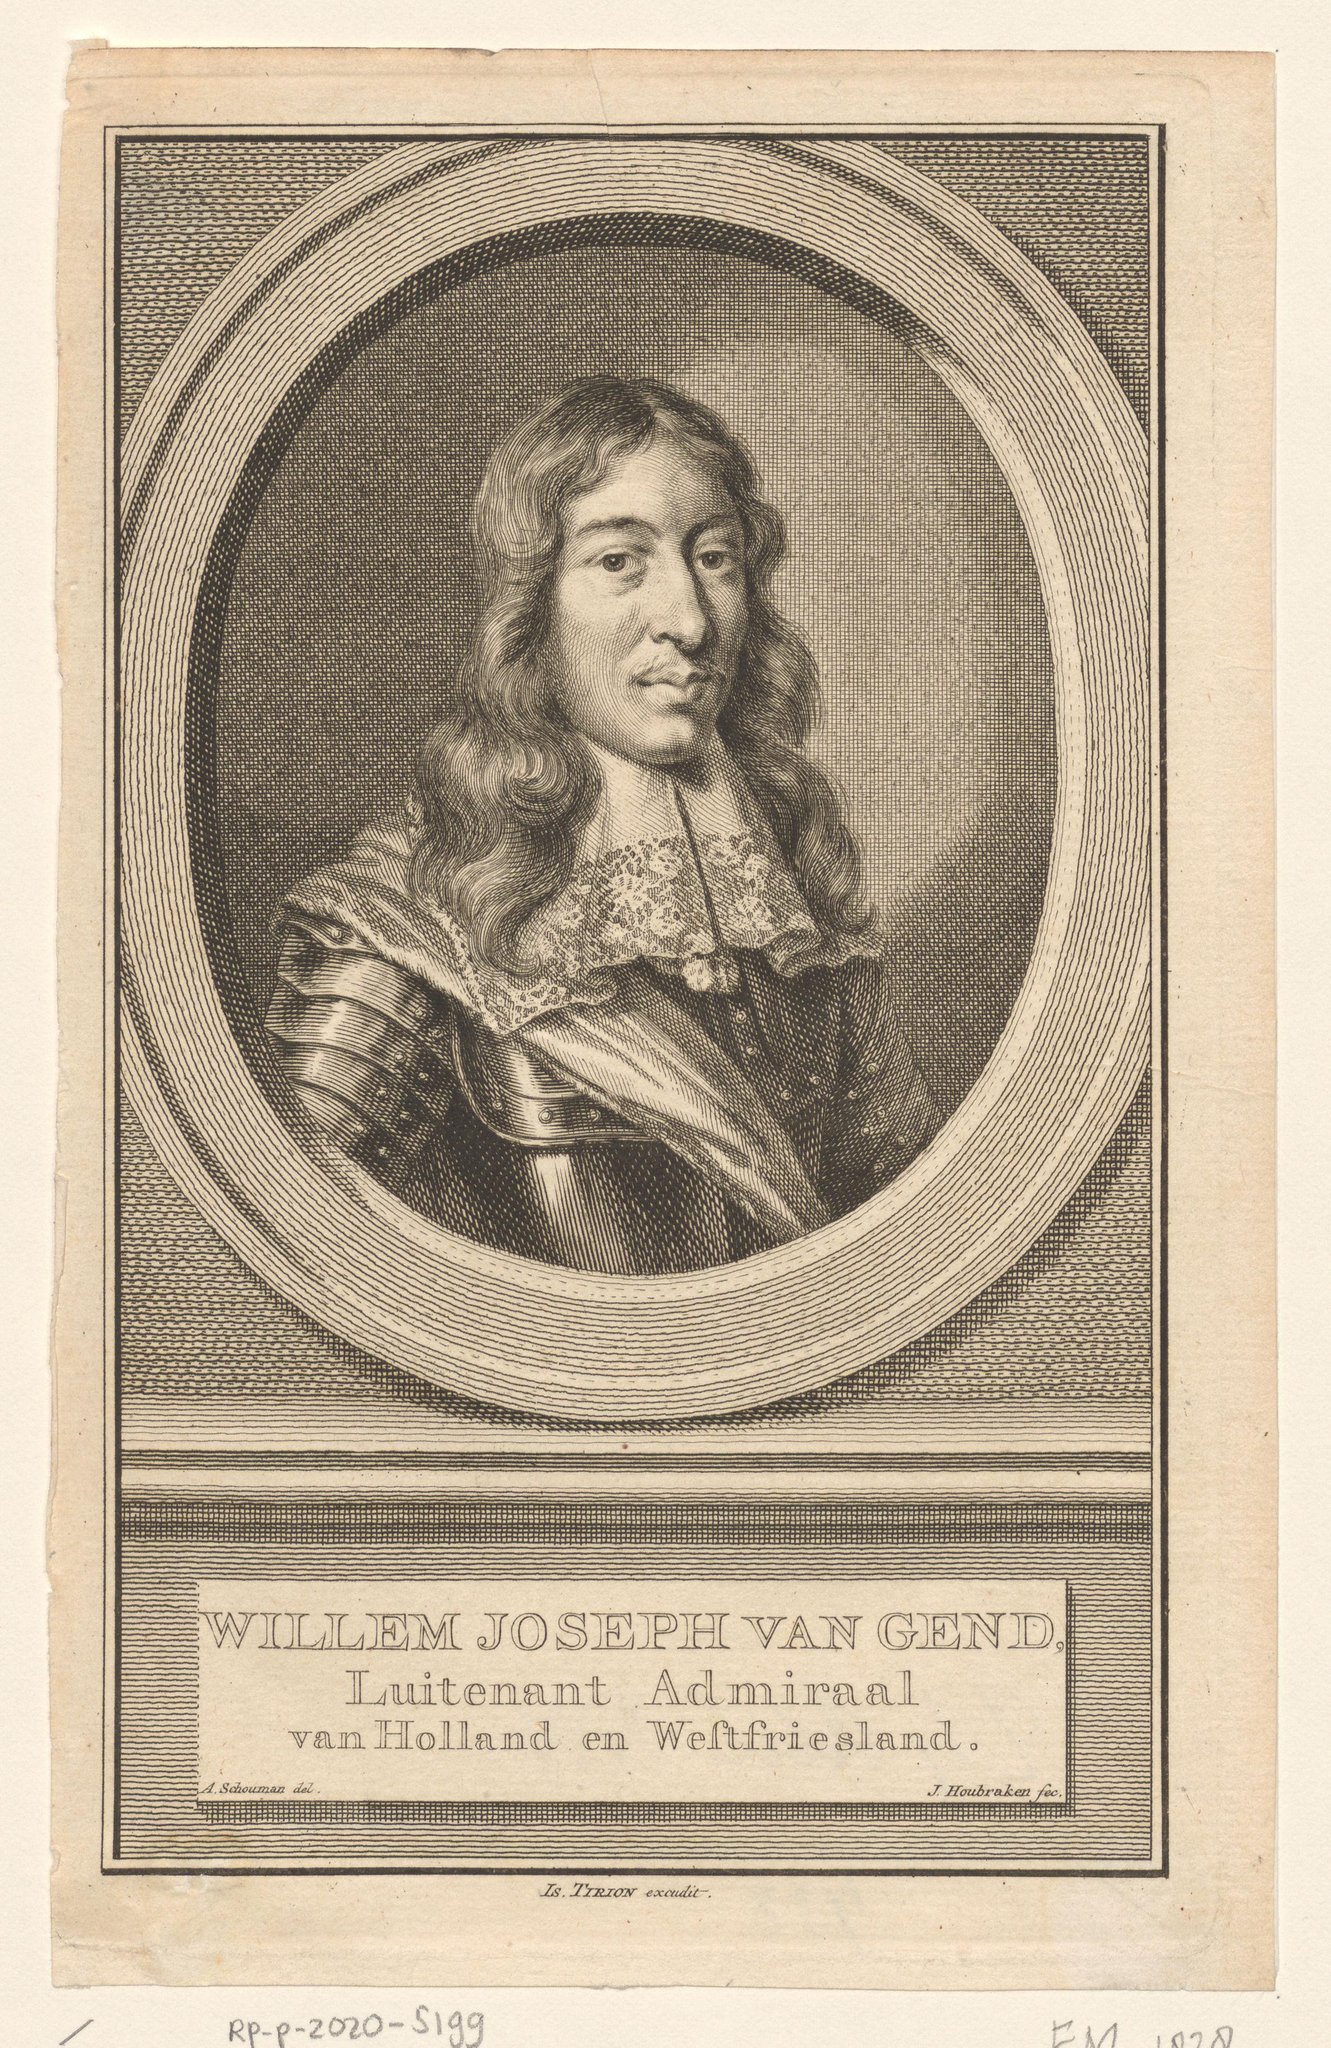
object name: print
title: Portret van Willem Joseph baron van Gendt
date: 1749-1759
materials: cardboard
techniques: engraving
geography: amsterdam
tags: willem joseph baron van gendt, historical persons, writer, poet, author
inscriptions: collector's mark: Lugt 2228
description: Prent uit: Wagenaar, Jan. Vaderlandsche historie, vervattende de geschiedenissen der nu Vereenigde Nederlanden, inzonderheid die van Holland (...). Amsterdam, Isaak Tirion, [1749-1759].